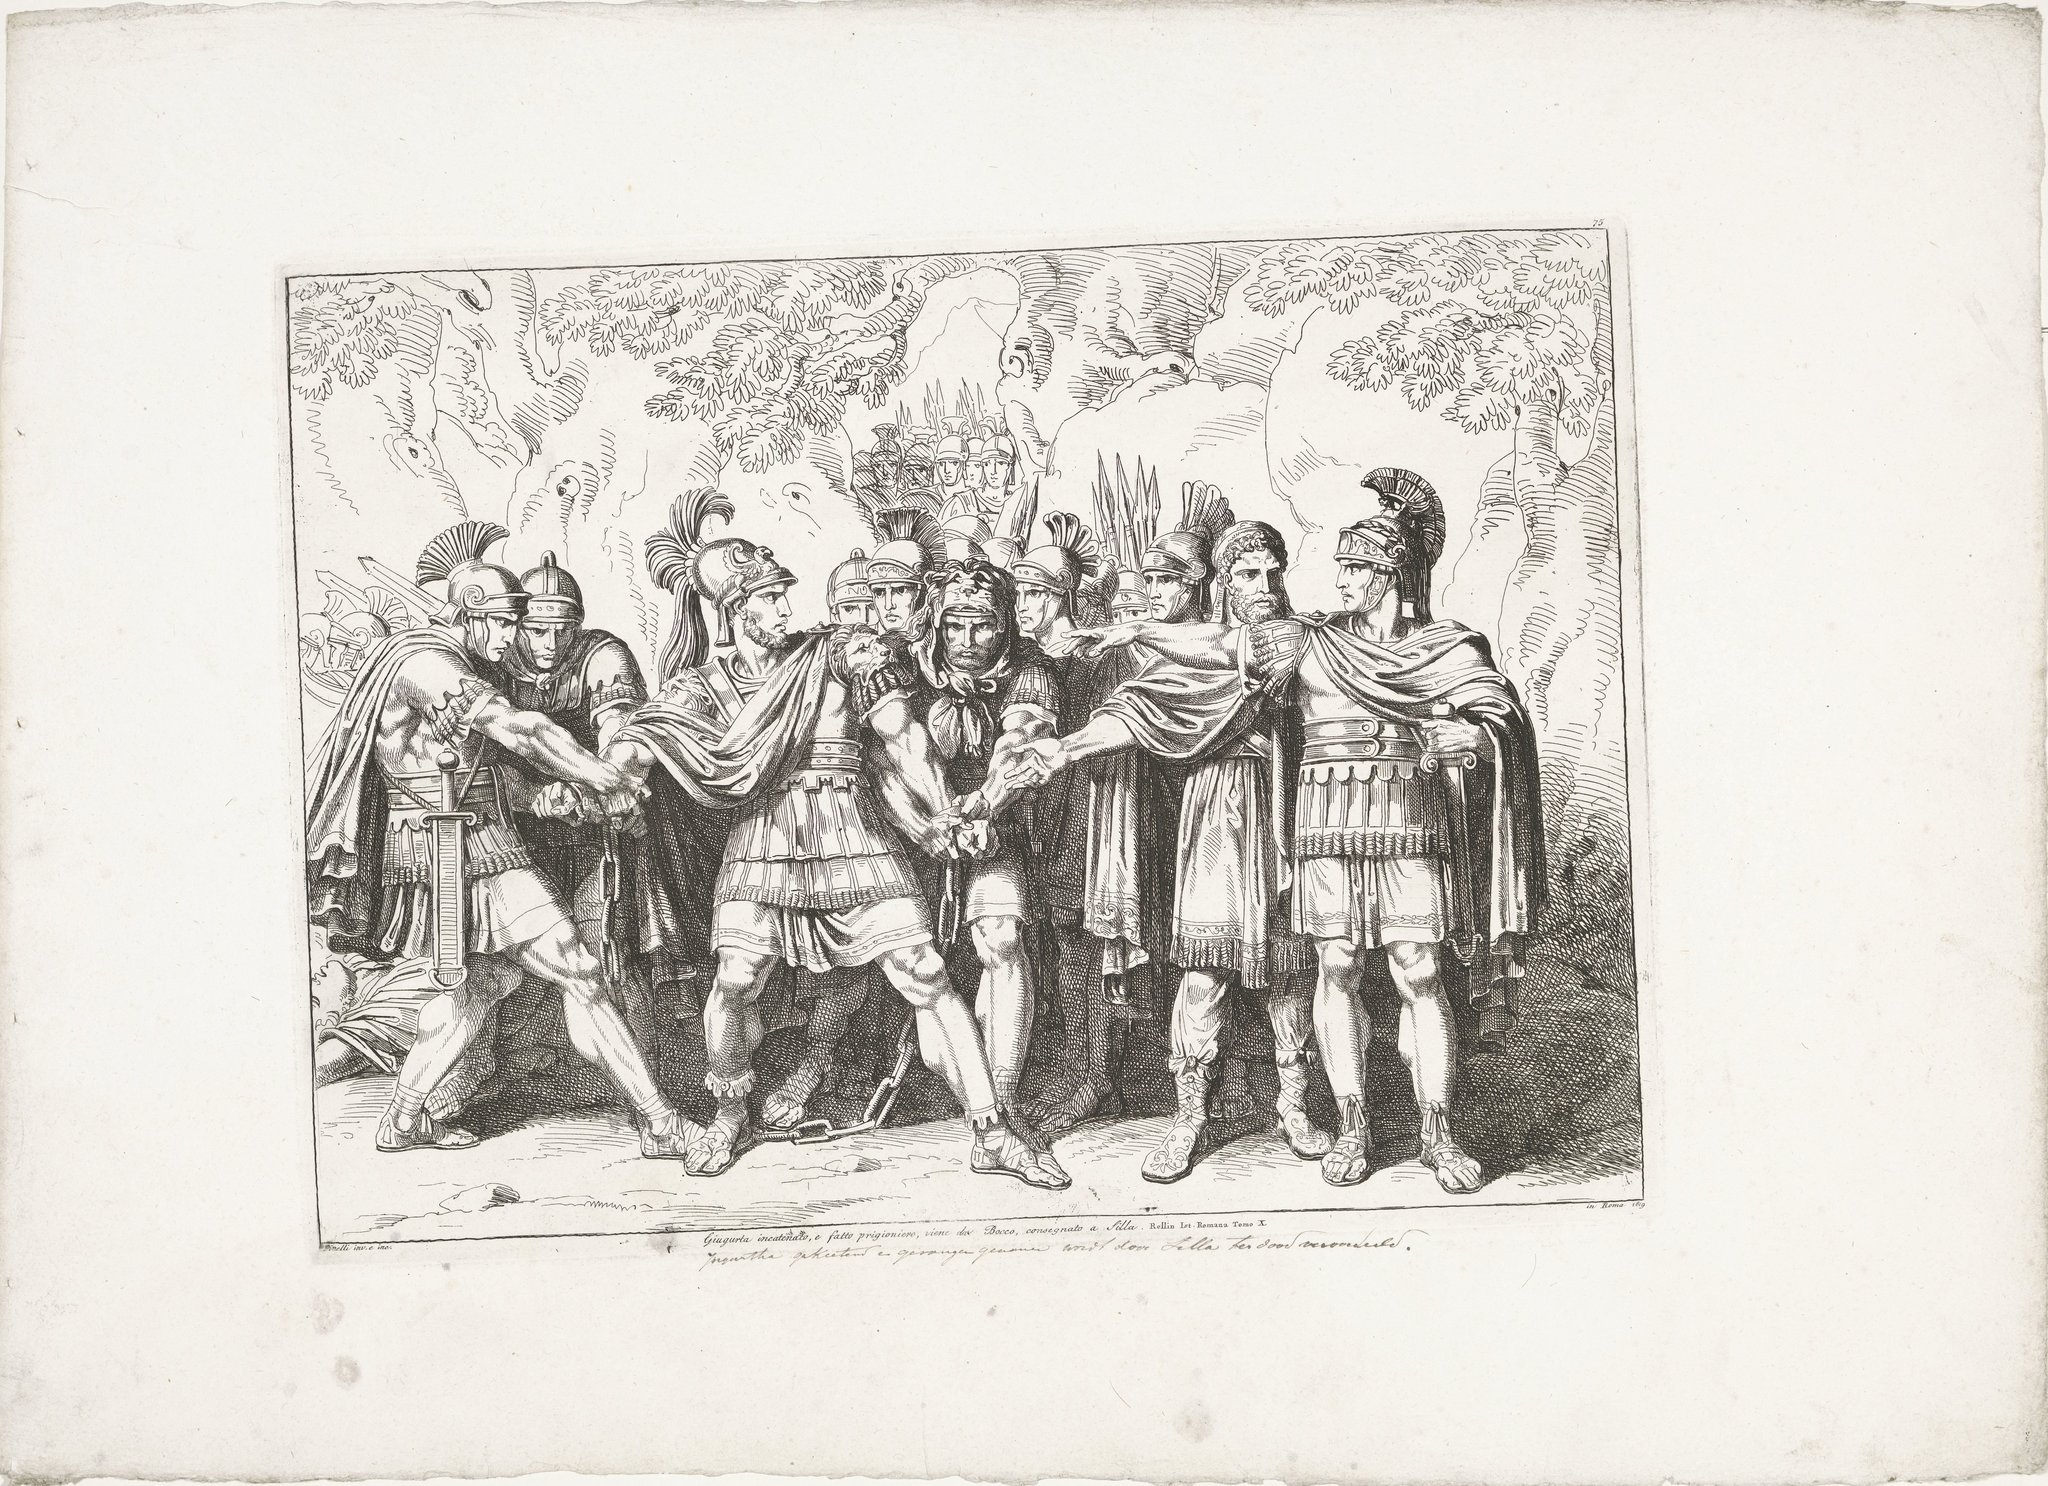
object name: print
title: Frontespizio della Istoria Romana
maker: bartolomeo pinelli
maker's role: draughtsman, print maker, sculptor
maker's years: 1781-1835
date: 1818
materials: paper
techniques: etching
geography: rome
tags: history, the soldier; the soldier's life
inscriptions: inscription: ‘Jugurtha gekeetend en gevangen genomen wordt door Silla ter dood veroordeeld.’, collector's mark: Lugt 2228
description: Deze prent maakt deel uit van een reeks van 101 prenten over de geschiedenis van Rome.